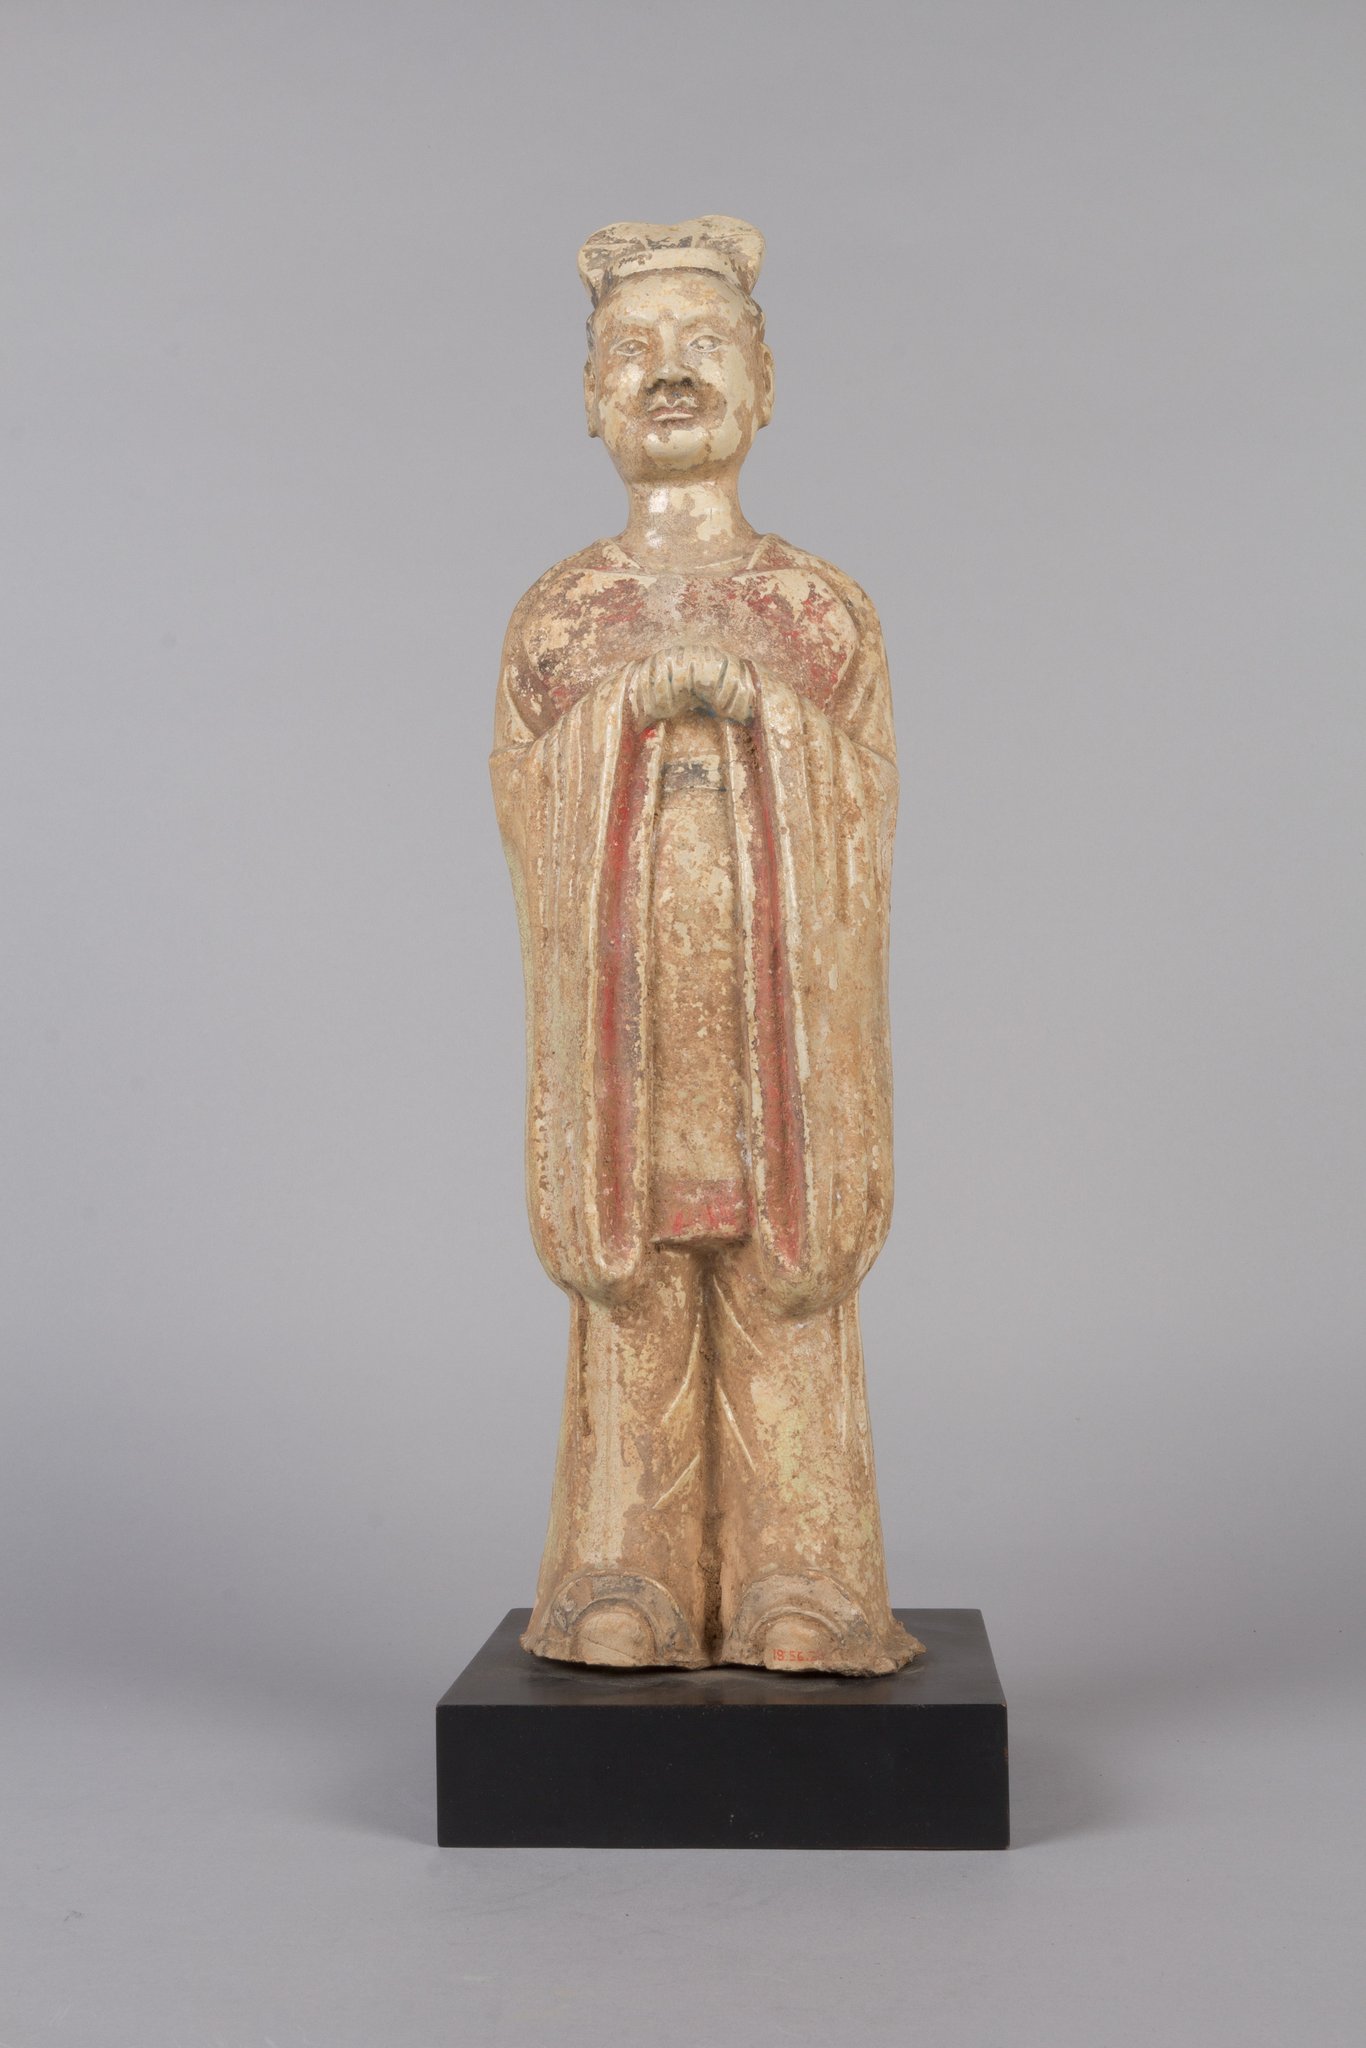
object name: figure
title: Figure of an Official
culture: chinese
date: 618-907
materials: earthenware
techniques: glazing